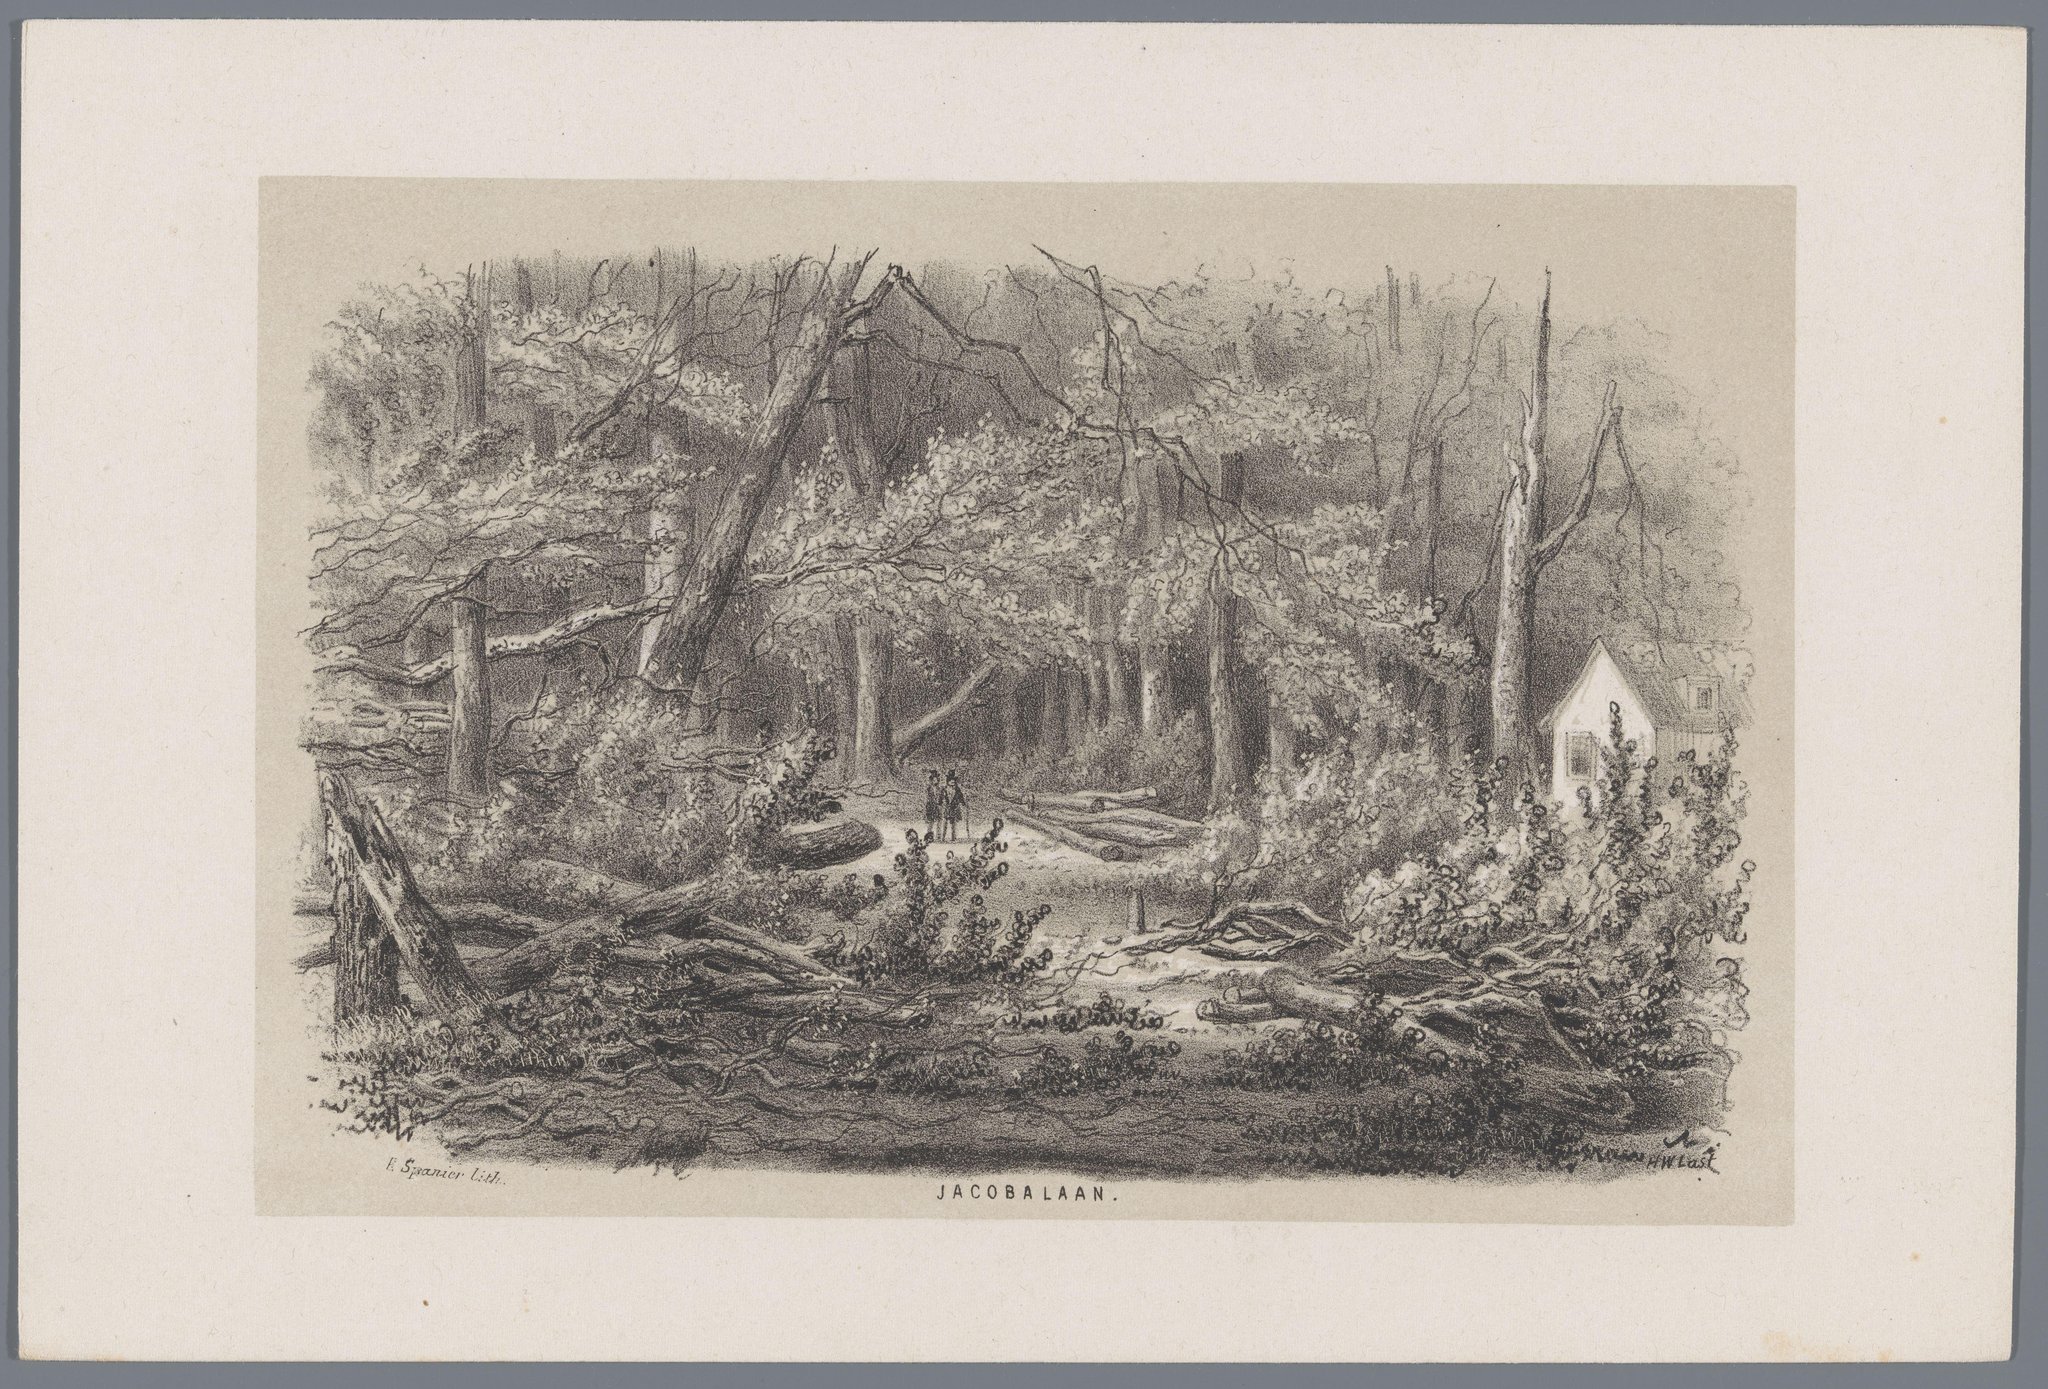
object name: print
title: Album van tien gelithographieerde schetsen, voorstellende Tooneelen van de Verwoesting, Aangerigt door den storm van 28 mei 1860 in het 's Gravenhaagsche Bosch, te Scheveningen, enz.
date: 1860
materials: paper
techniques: tone lithography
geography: the hague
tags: storm on land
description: Omgewaaide bomen aan de Jacobalaan, na de storm. Onderdeel van het album met tien losse steendrukken in een papieren omslag met voorstellingen van de schade aangericht door de 'Pinksterstorm' van 28 mei 1860 in het Haagse Bos en omgeving.